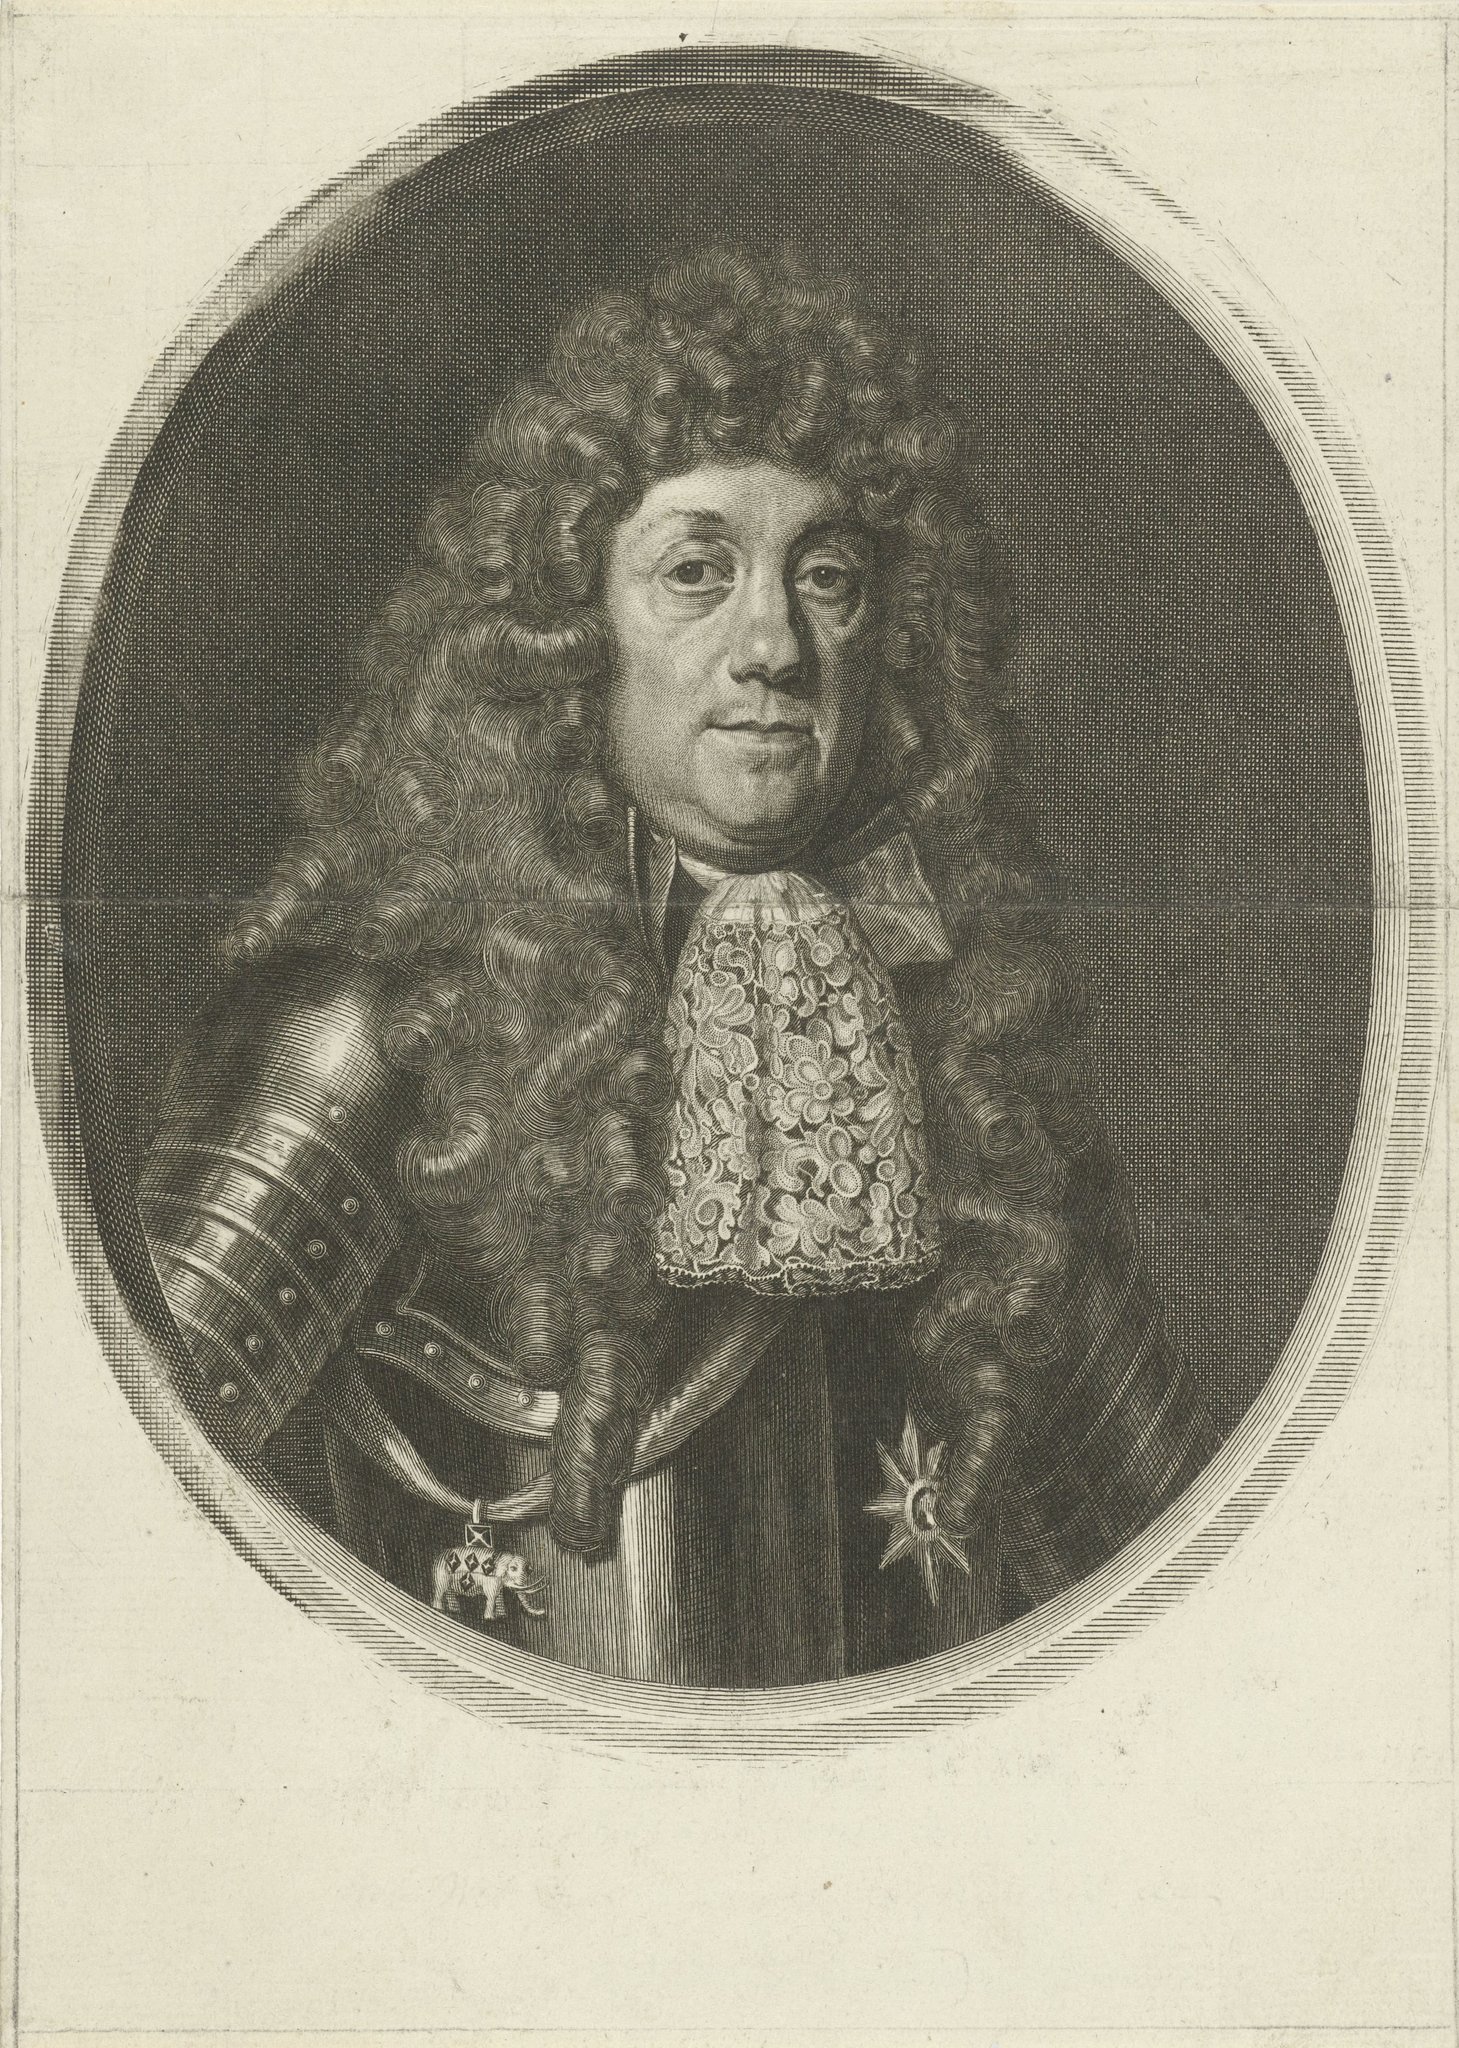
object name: print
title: Portret van Cornelis Tromp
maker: jan van munnickhuysen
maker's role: draughtsman, print maker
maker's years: 1655-1701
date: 1664-1721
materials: paper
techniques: engraving, etching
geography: netherlands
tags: rotterdam, amsterdam, cornelis tromp, armour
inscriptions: collector's mark: Lugt 2228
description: Portret van Cornelis Tromp, vlootvoogd, met aan een lint het ordeteken van de Orde van de Olifant.